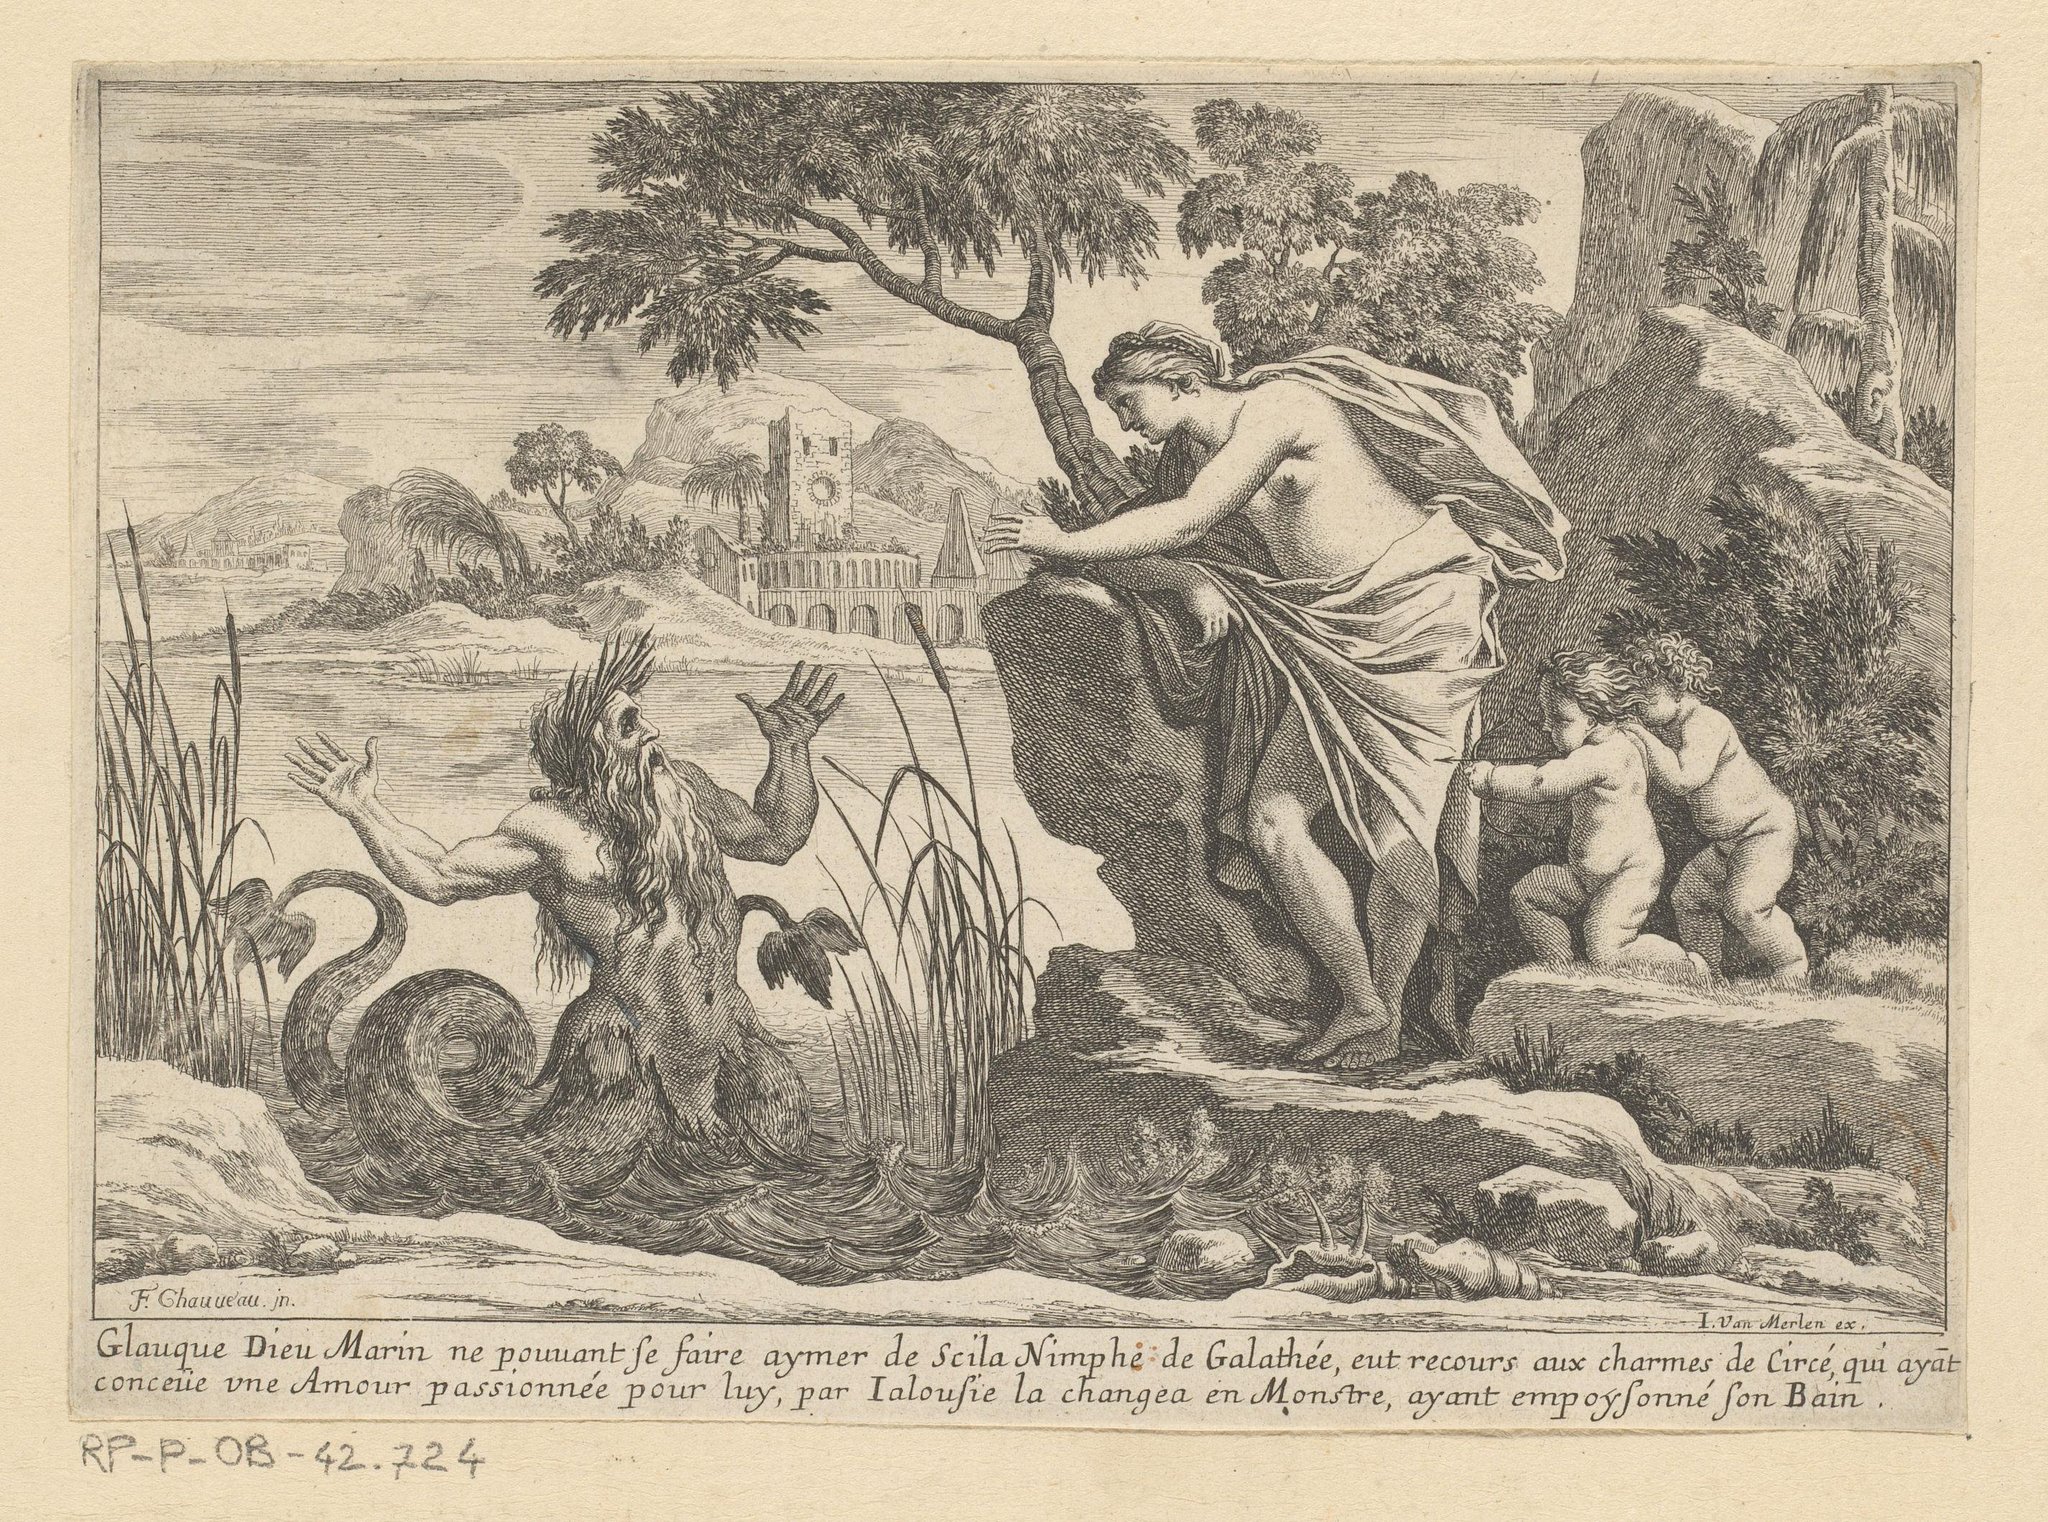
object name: print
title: Glaucus en Scylla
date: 1623-1676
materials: paper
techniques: engraving, etching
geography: paris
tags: glaucus appeals to circe for assistance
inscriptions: collector's mark: Lugt 240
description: Maakt deel uit van een zesdelige serie met scènes uit de Metamorfosen van Ovidius. De serie werd uitgegeven in Parijs door Jacques van Merlen.